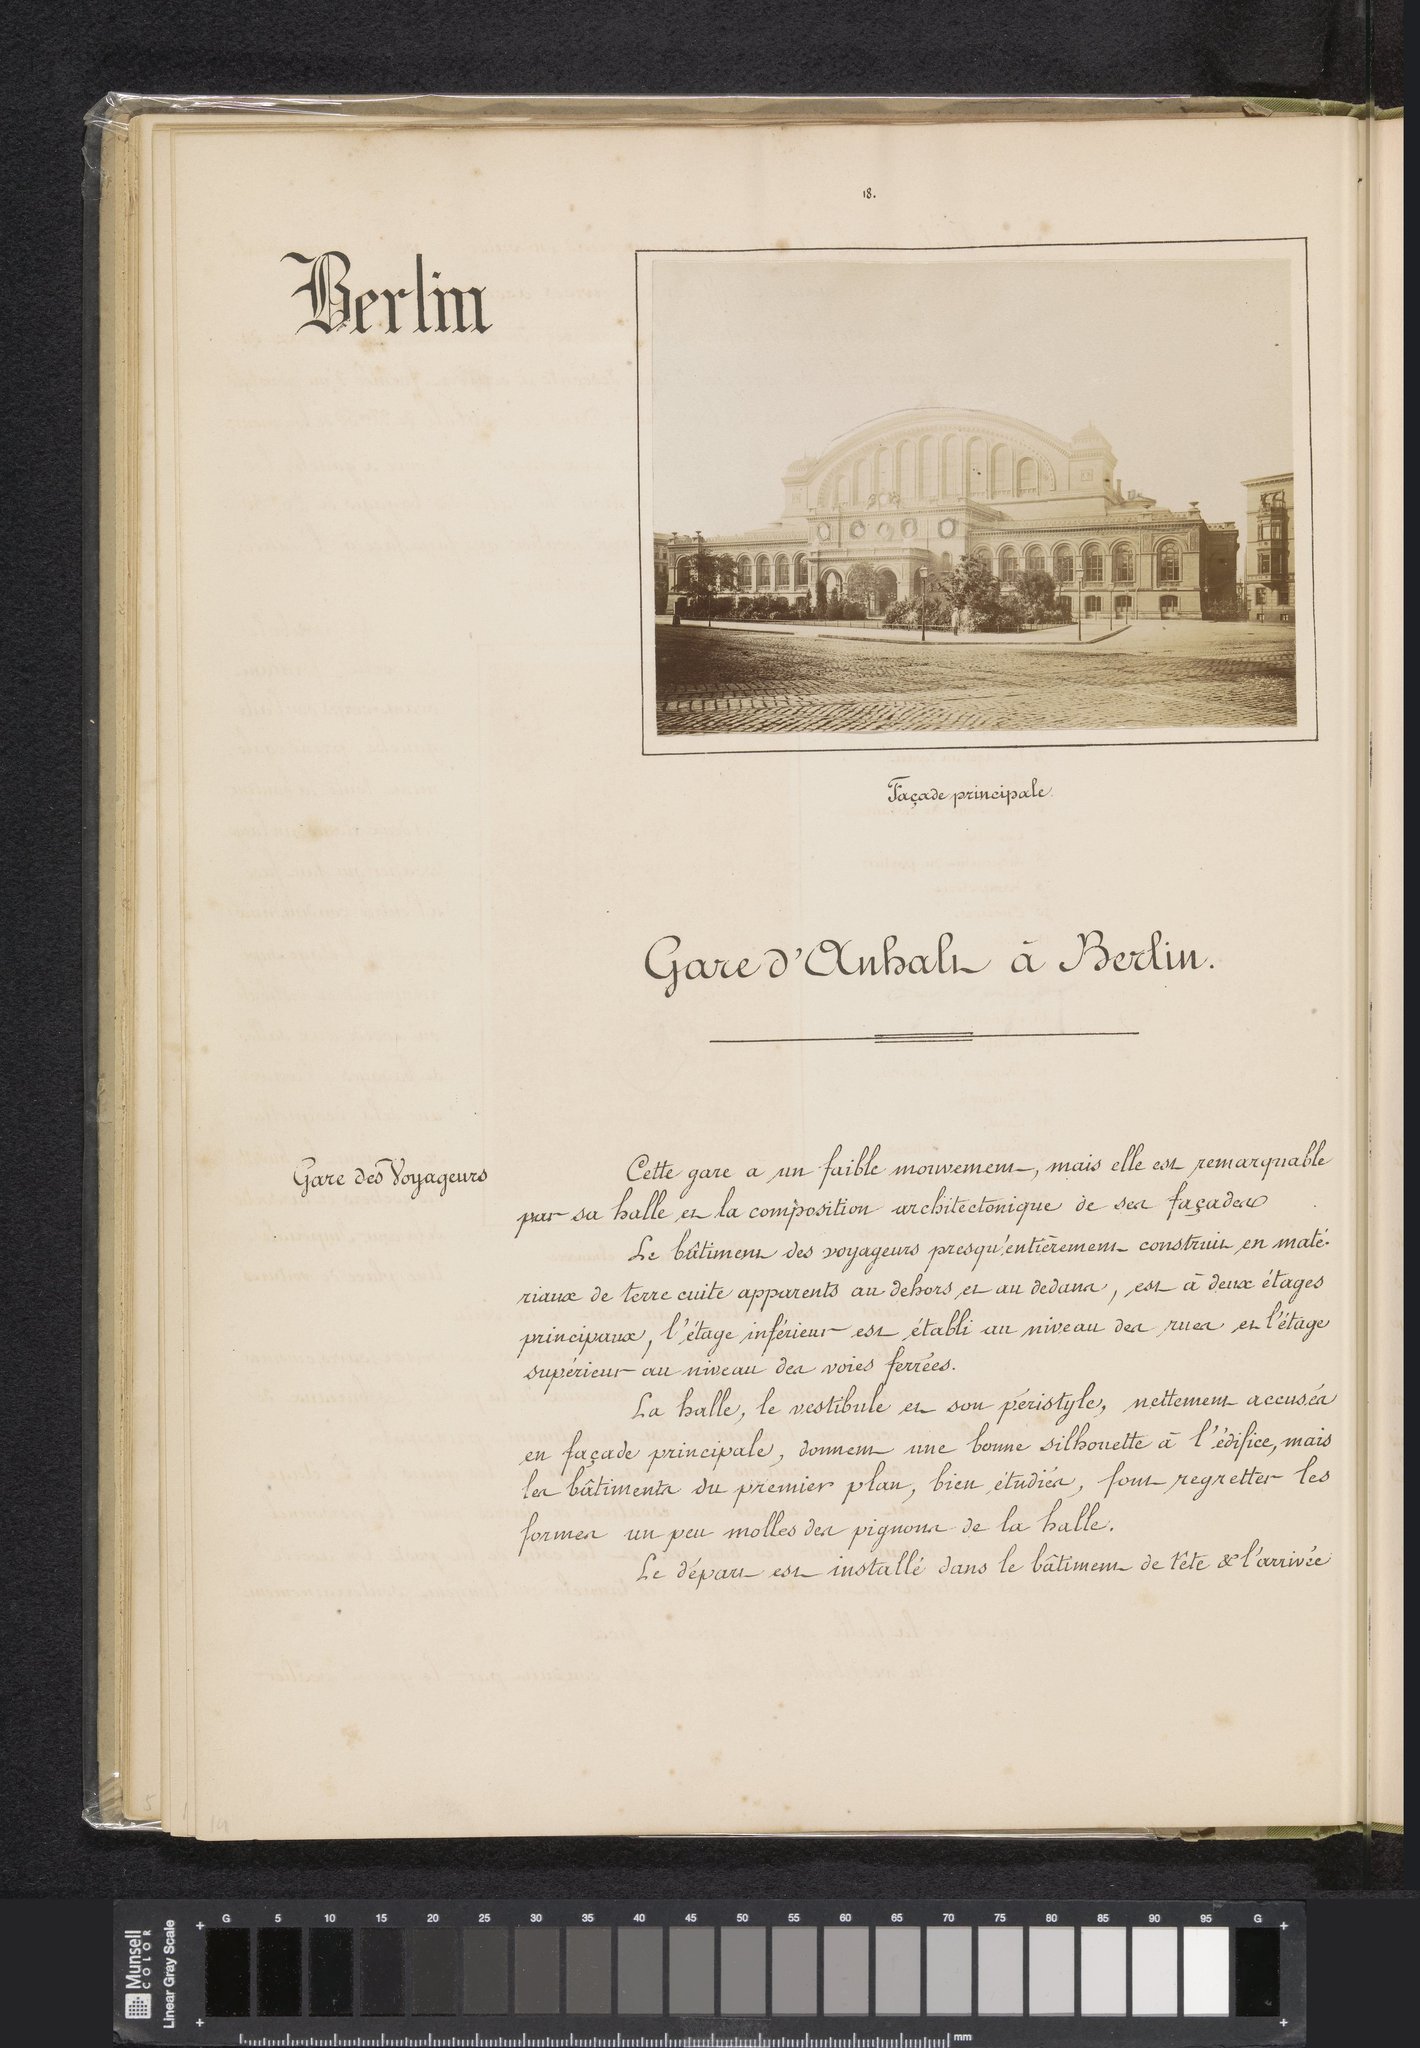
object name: photograph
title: Façade principale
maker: Anonymous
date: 1874-1884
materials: photographic support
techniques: albumen print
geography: berlin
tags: railway, train, façade (of house or building), station; shelter (railway, tramway)